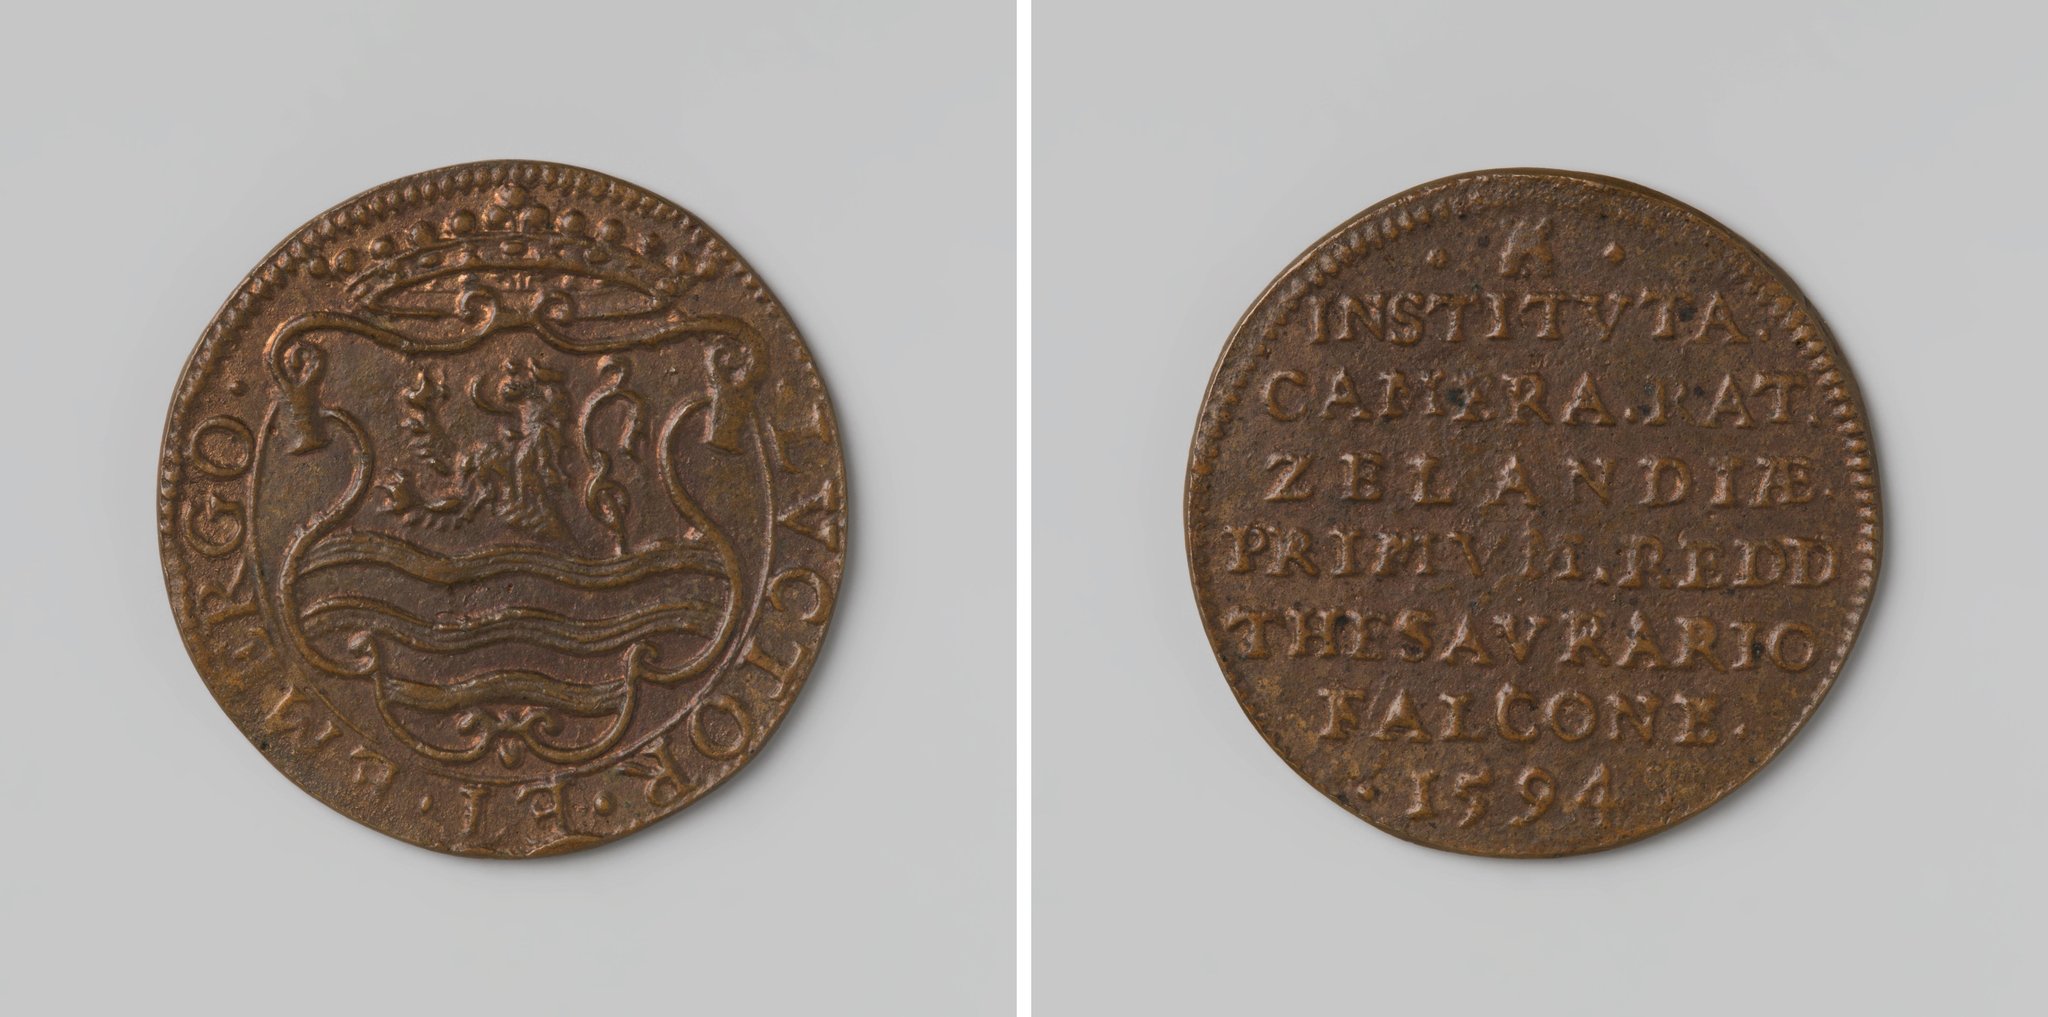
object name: jeton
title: Oprichting van de rekenkamer van Zeeland te Middelburg met Jacob Valk als eerste thesaurier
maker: Anonymous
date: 1594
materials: copper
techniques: striking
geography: middelburg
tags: middelburg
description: Koperen penning. Voorzijde: gekroond wapenschild binnen omschrift. Keerzijde: opschrift